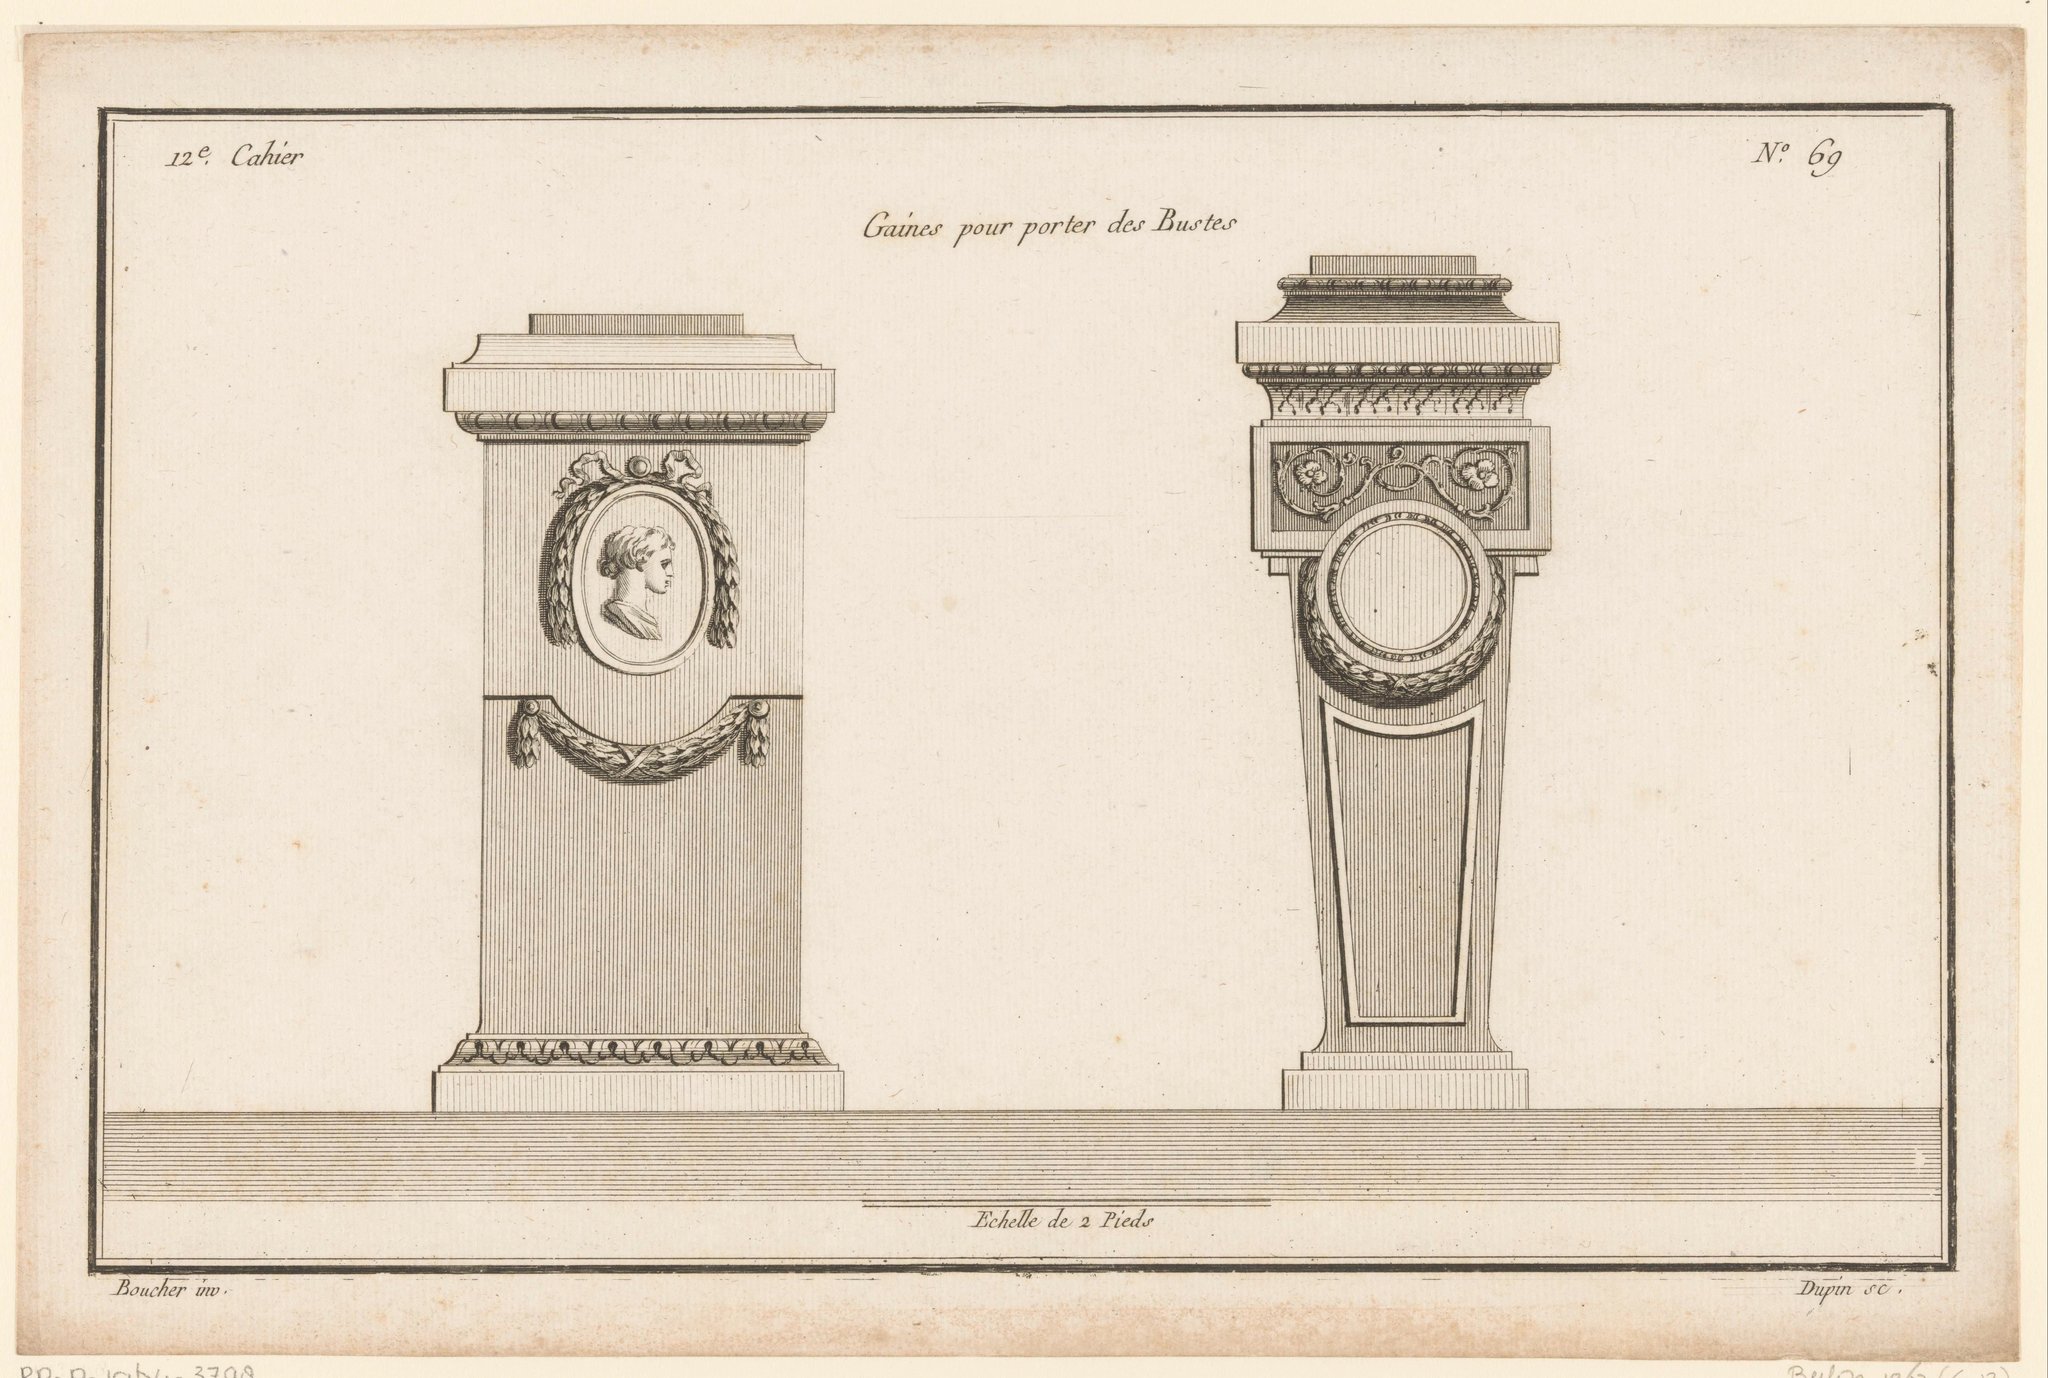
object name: ornament print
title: Gaines pour portes des Bustes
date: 1772-1779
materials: paper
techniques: engraving, etching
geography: paris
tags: ornament ~ medallion, pedestal of a piece of sculpture (perhaps in the form of a herm)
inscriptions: collector's mark: Lugt 2228, collector's mark: Lugt 2760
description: Twee geornamenteerde voetstukken met guirlandes en medaillons, links met portret en profil. Prentnummer 69.